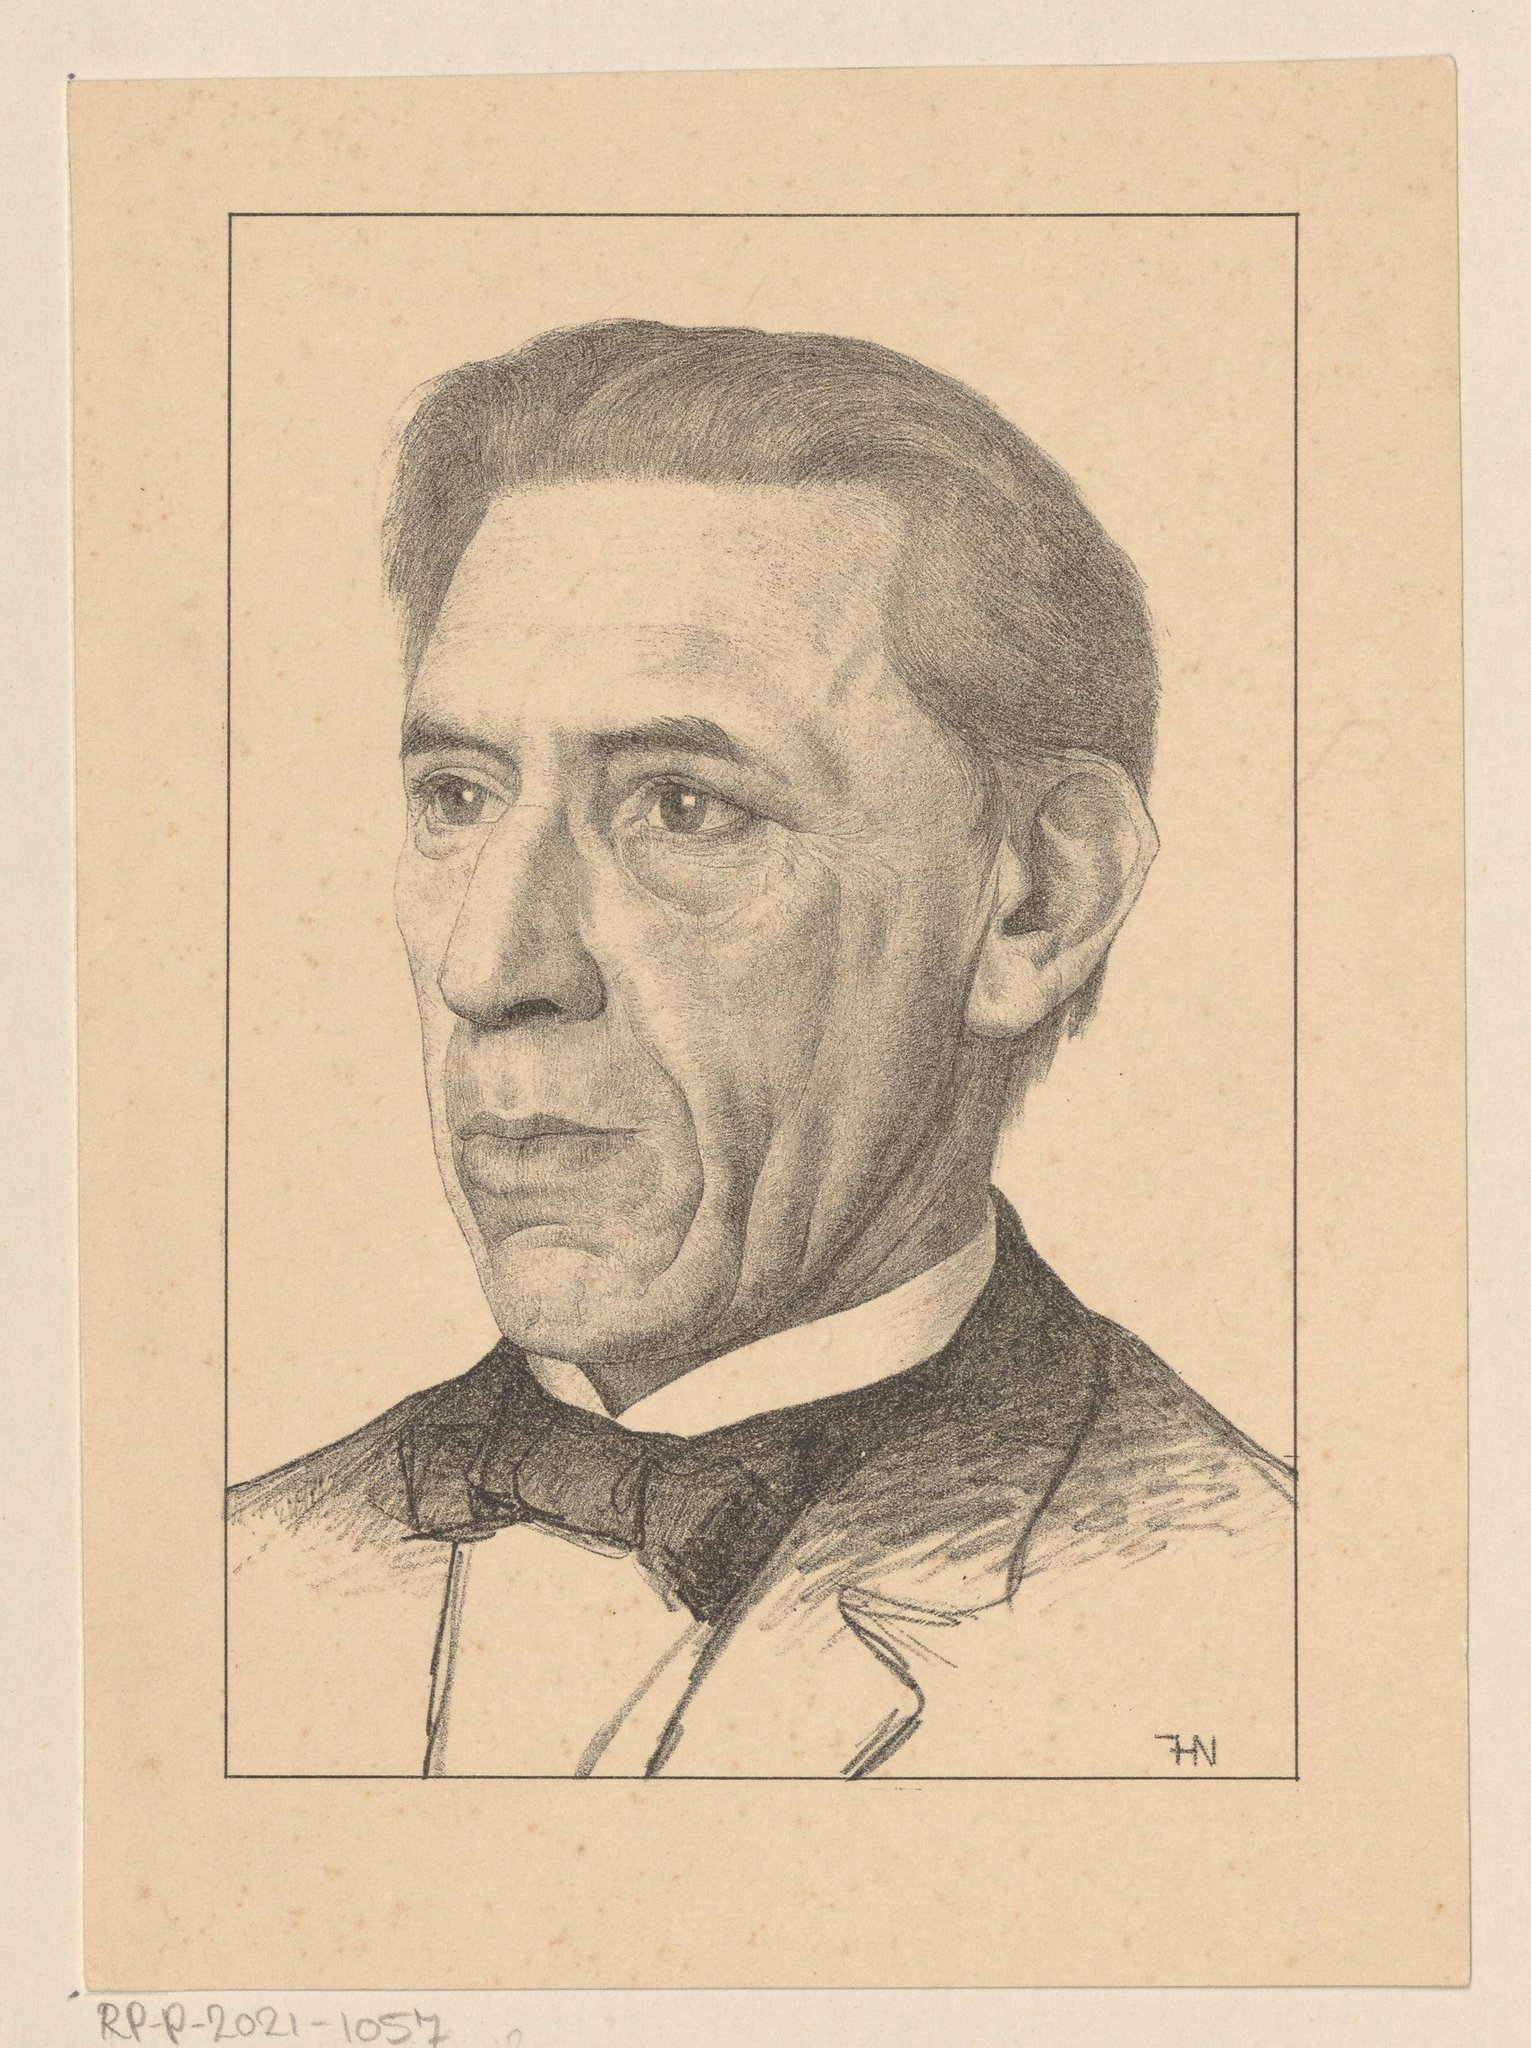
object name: print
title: Portret van Portret van Herman Thomas Karsten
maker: ferdinand hart nibbrig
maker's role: draughtsman, painter, print maker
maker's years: 1866-1915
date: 1876-1904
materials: paper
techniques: lithograph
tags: amsterdam, historical persons, portrait, self-portrait of architect